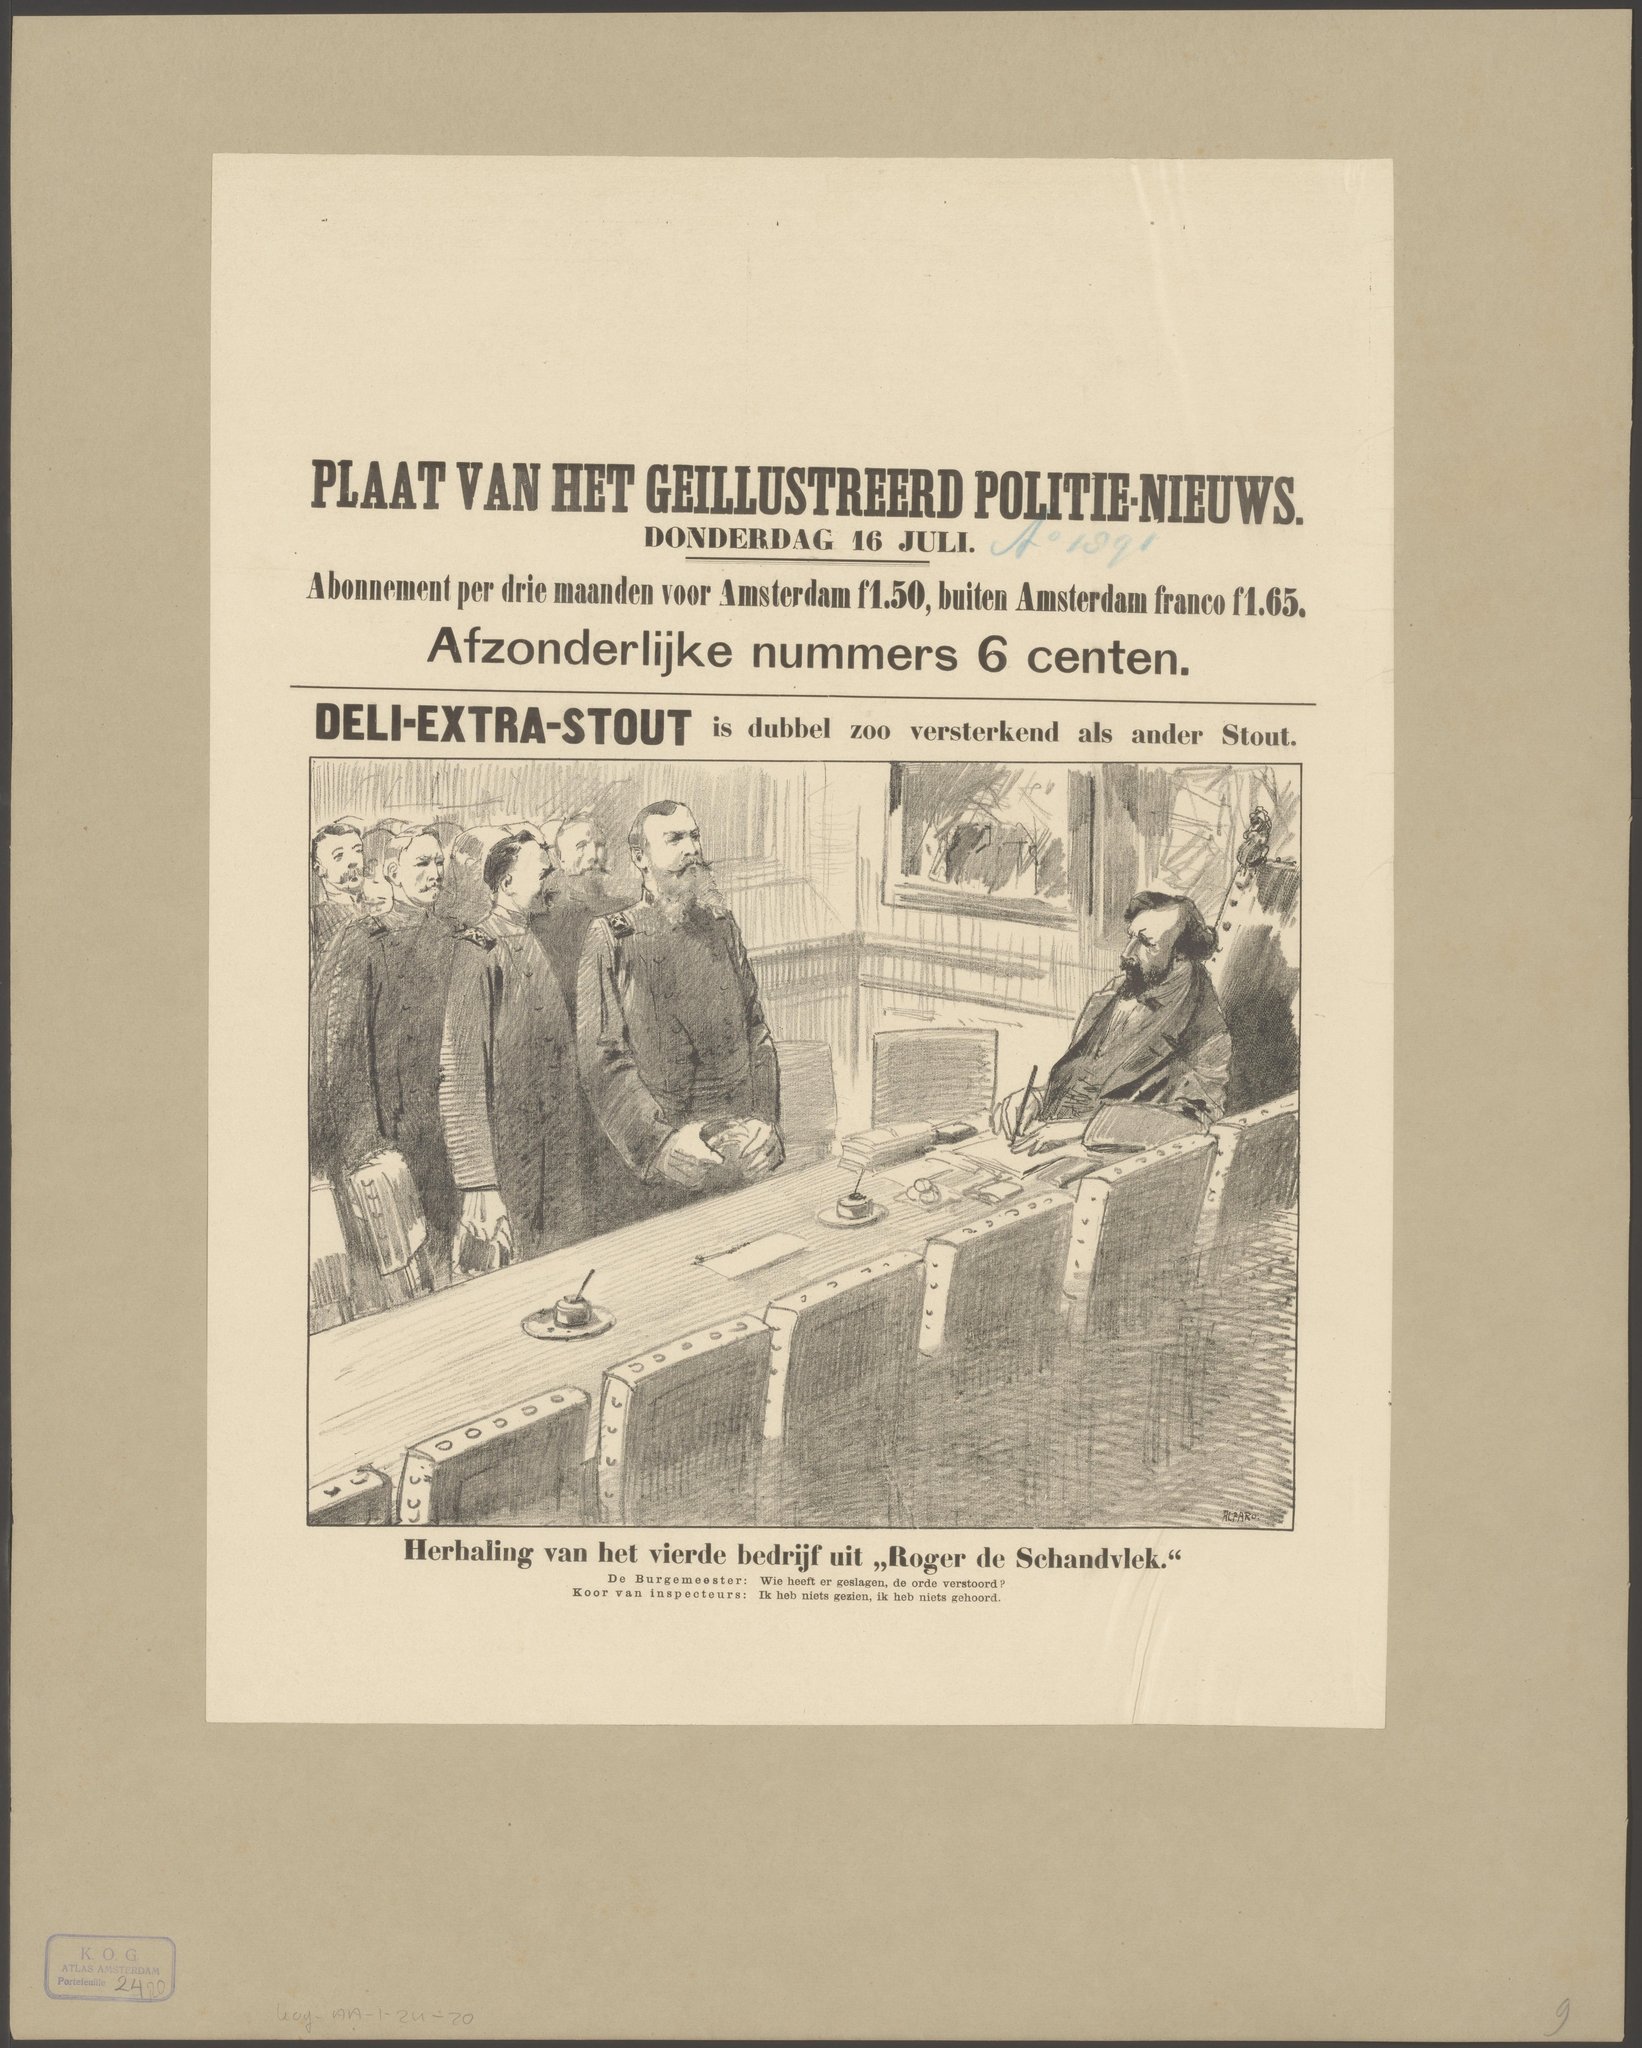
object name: cartoon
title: Herhaling van het vierde bedrijf uit "Roger de Schandvlek"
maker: alfaro reijding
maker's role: draughtsman, engineer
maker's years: 1863-1930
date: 1891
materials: paper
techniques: letterpress printing, lithograph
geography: amsterdam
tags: mayor, gijsbert van tienhoven, political caricatures and satires, police, amsterdam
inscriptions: collector's mark: Lugt 1641b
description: Gepubliceerd als bijvoegsel van 'Geïllustreerd Politie-Nieuws', 16 juli 1891.